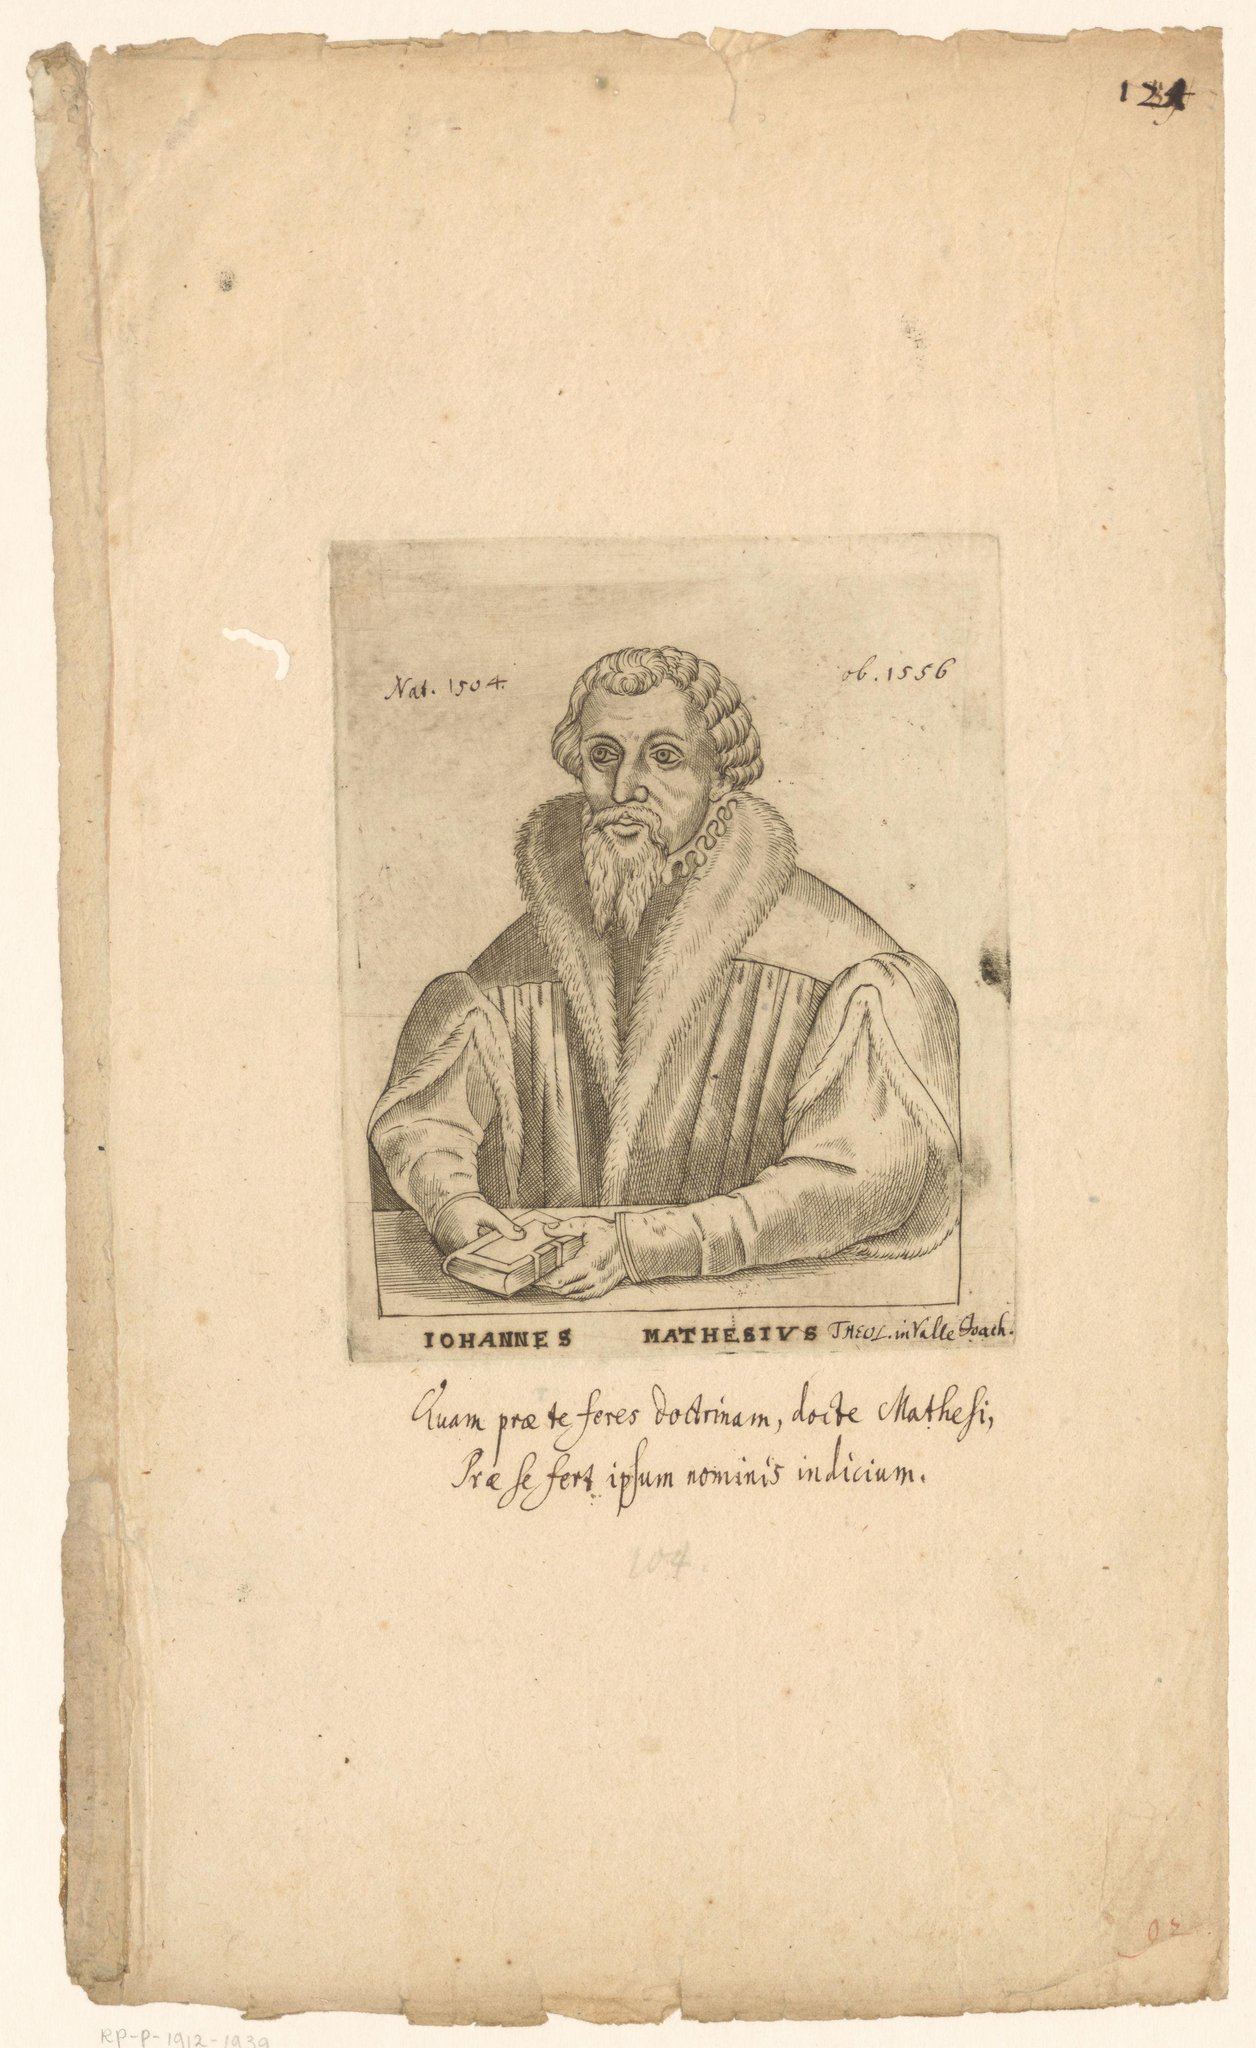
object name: print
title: Portret van Johannes Mathesius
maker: Anonymous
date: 1563-1642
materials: paper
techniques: engraving, etching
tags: theologian, historical persons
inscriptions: number, annotation: ‘Quam praete fere doctrinam, docte mathesi, prefefert ipsum nominis indicium.’, collector's mark: Lugt 2228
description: Deze prent (een impressie) hoort bij een serie portretten van sturende personen tijdens de reformatie.